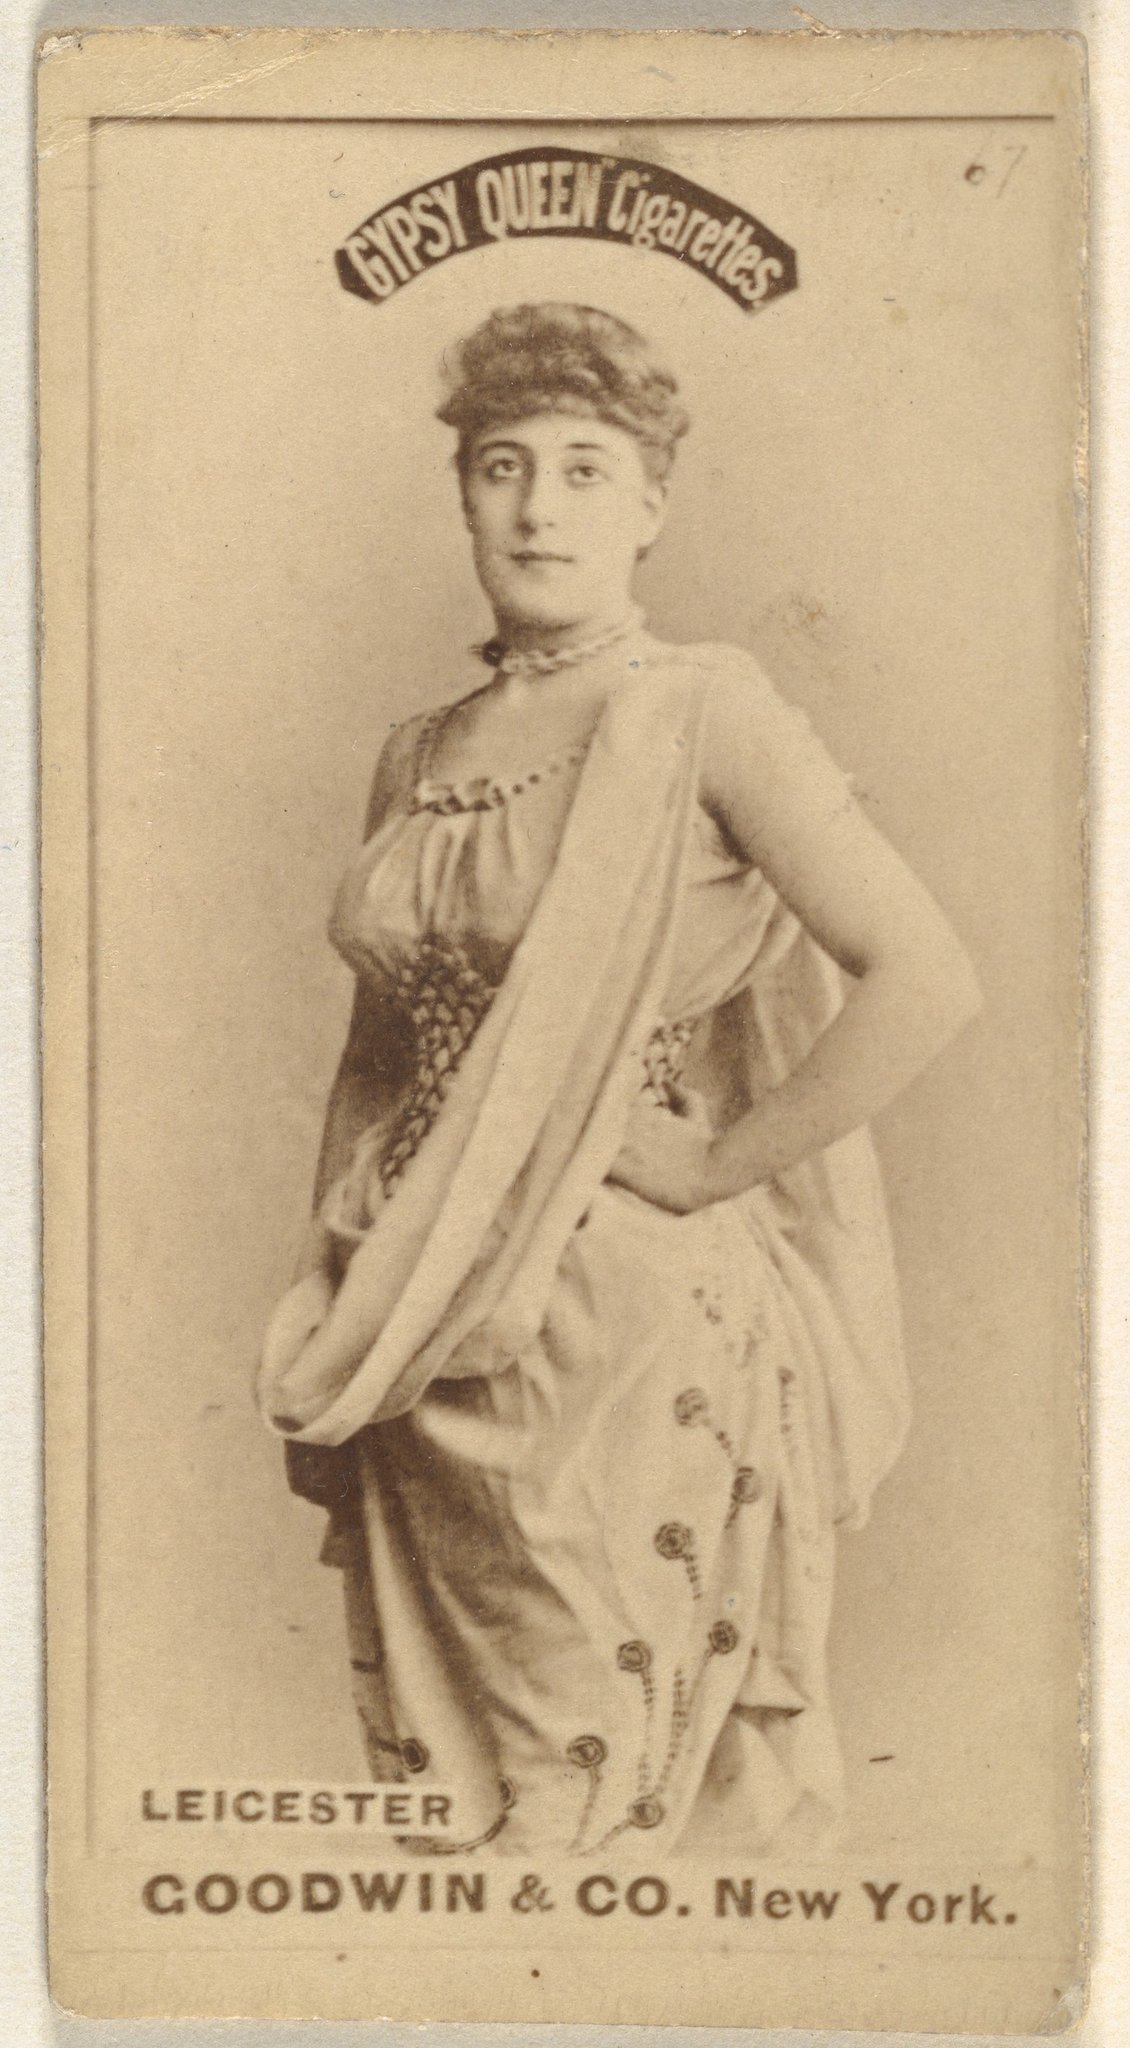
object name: photograph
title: Leicester, from the Actors and Actresses series (N171) for Gypsy Queen Cigarettes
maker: goodwin & company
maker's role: publisher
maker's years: 1850-1950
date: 1886-1890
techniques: albumen silver print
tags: portraits,women,actresses